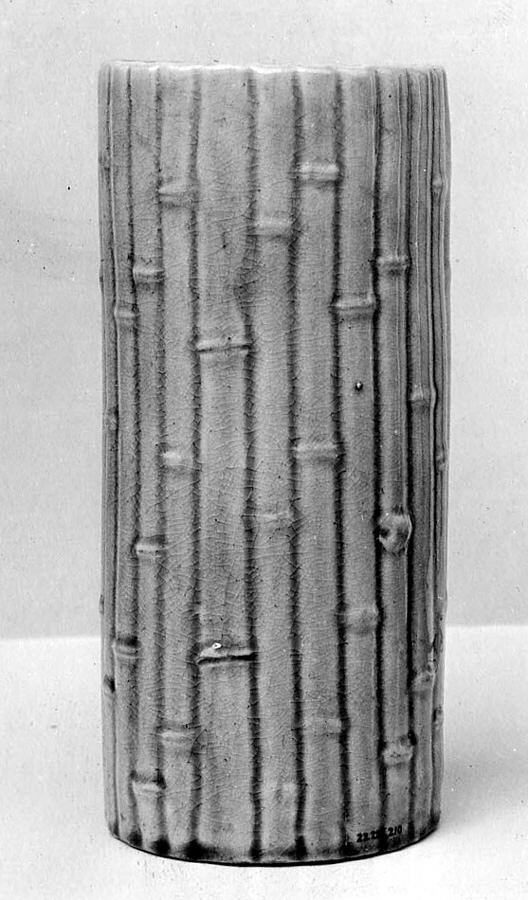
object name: vase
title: Vase in the Shape of a Bundle of Bamboo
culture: japanese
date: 1851-1900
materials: glaze, porcelain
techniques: molding, relief